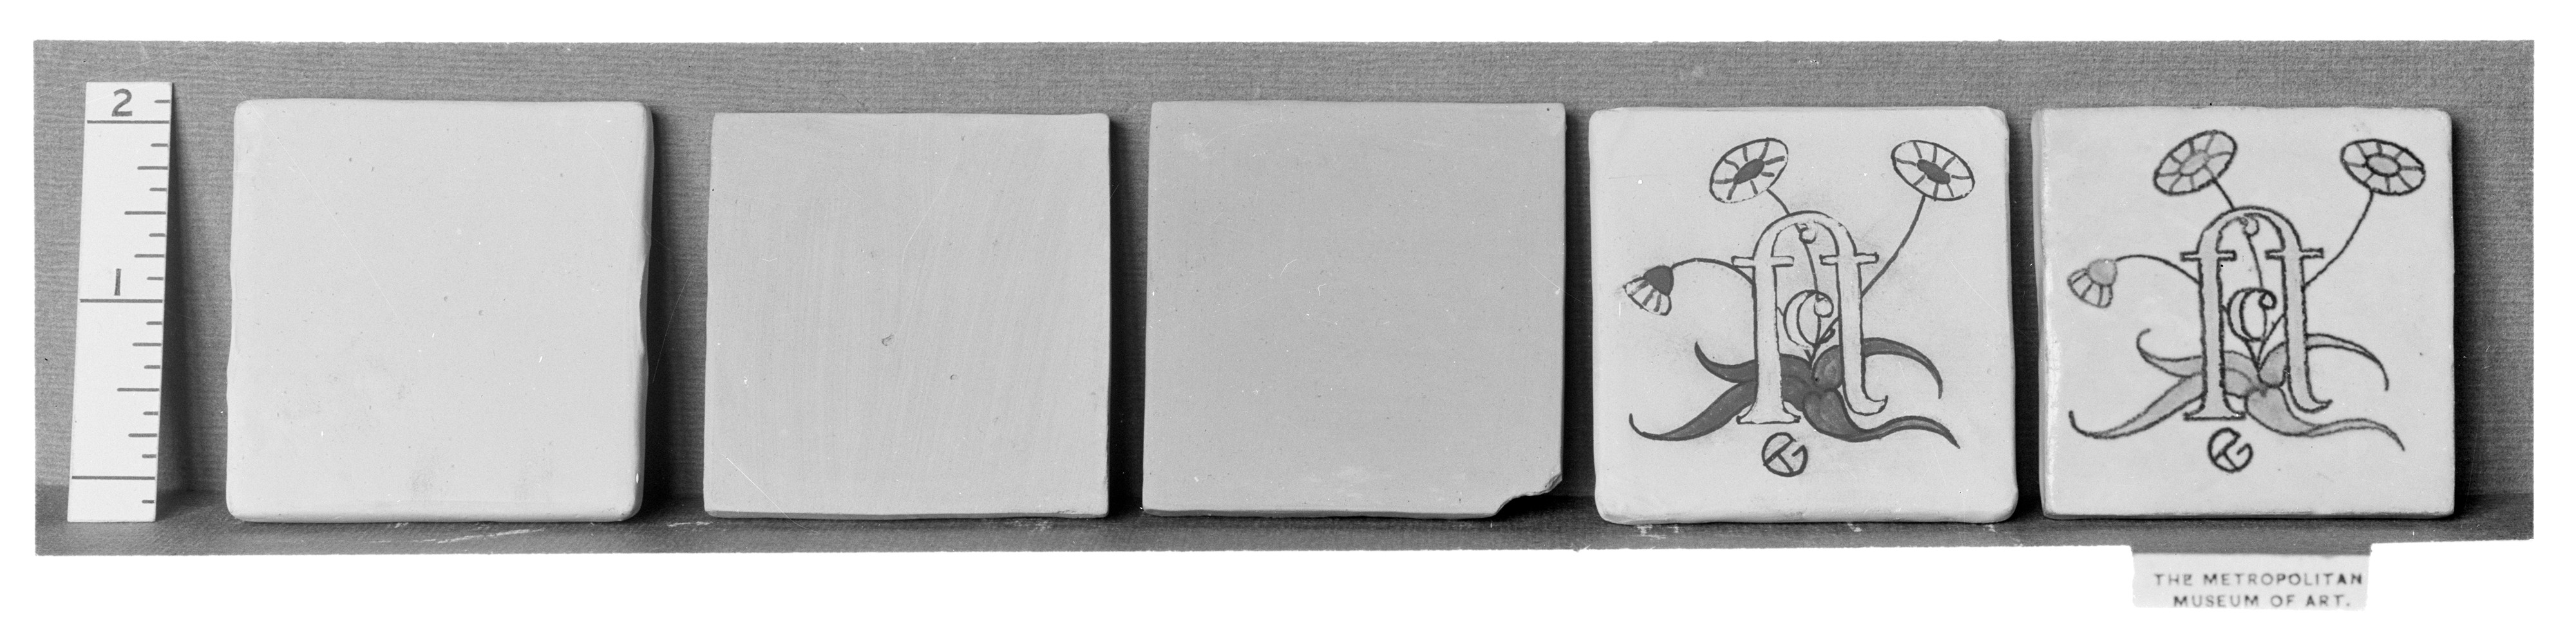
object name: tile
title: Set of five tiles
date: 1901-2000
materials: pottery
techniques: glazing